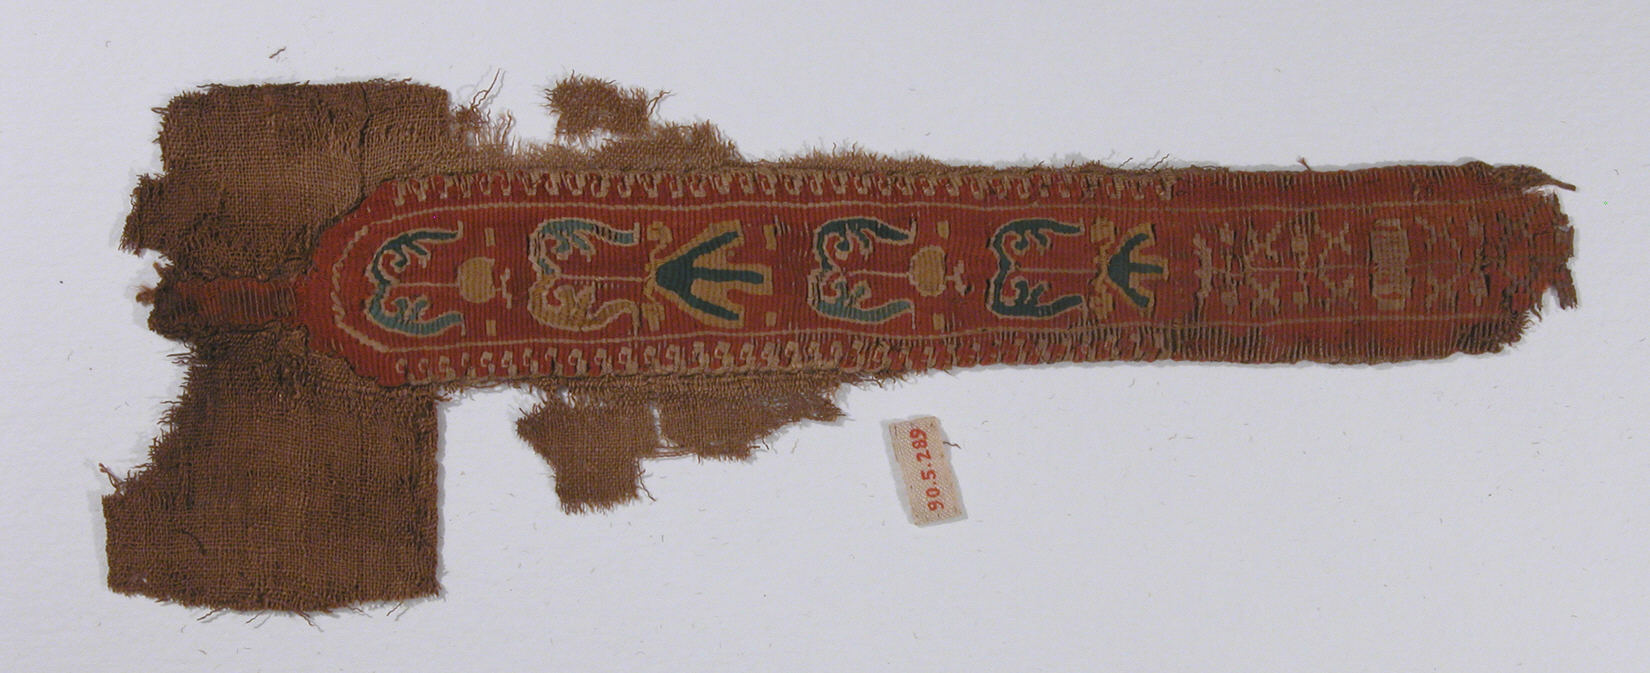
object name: textile fragment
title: Fragment of a Tunic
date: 401-600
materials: linen, wool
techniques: weave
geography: egypt